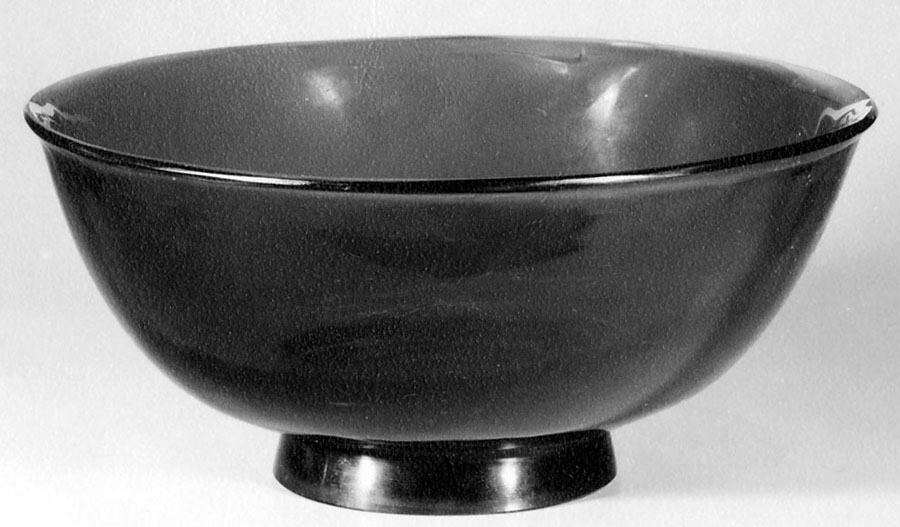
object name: bowl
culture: chinese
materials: glass